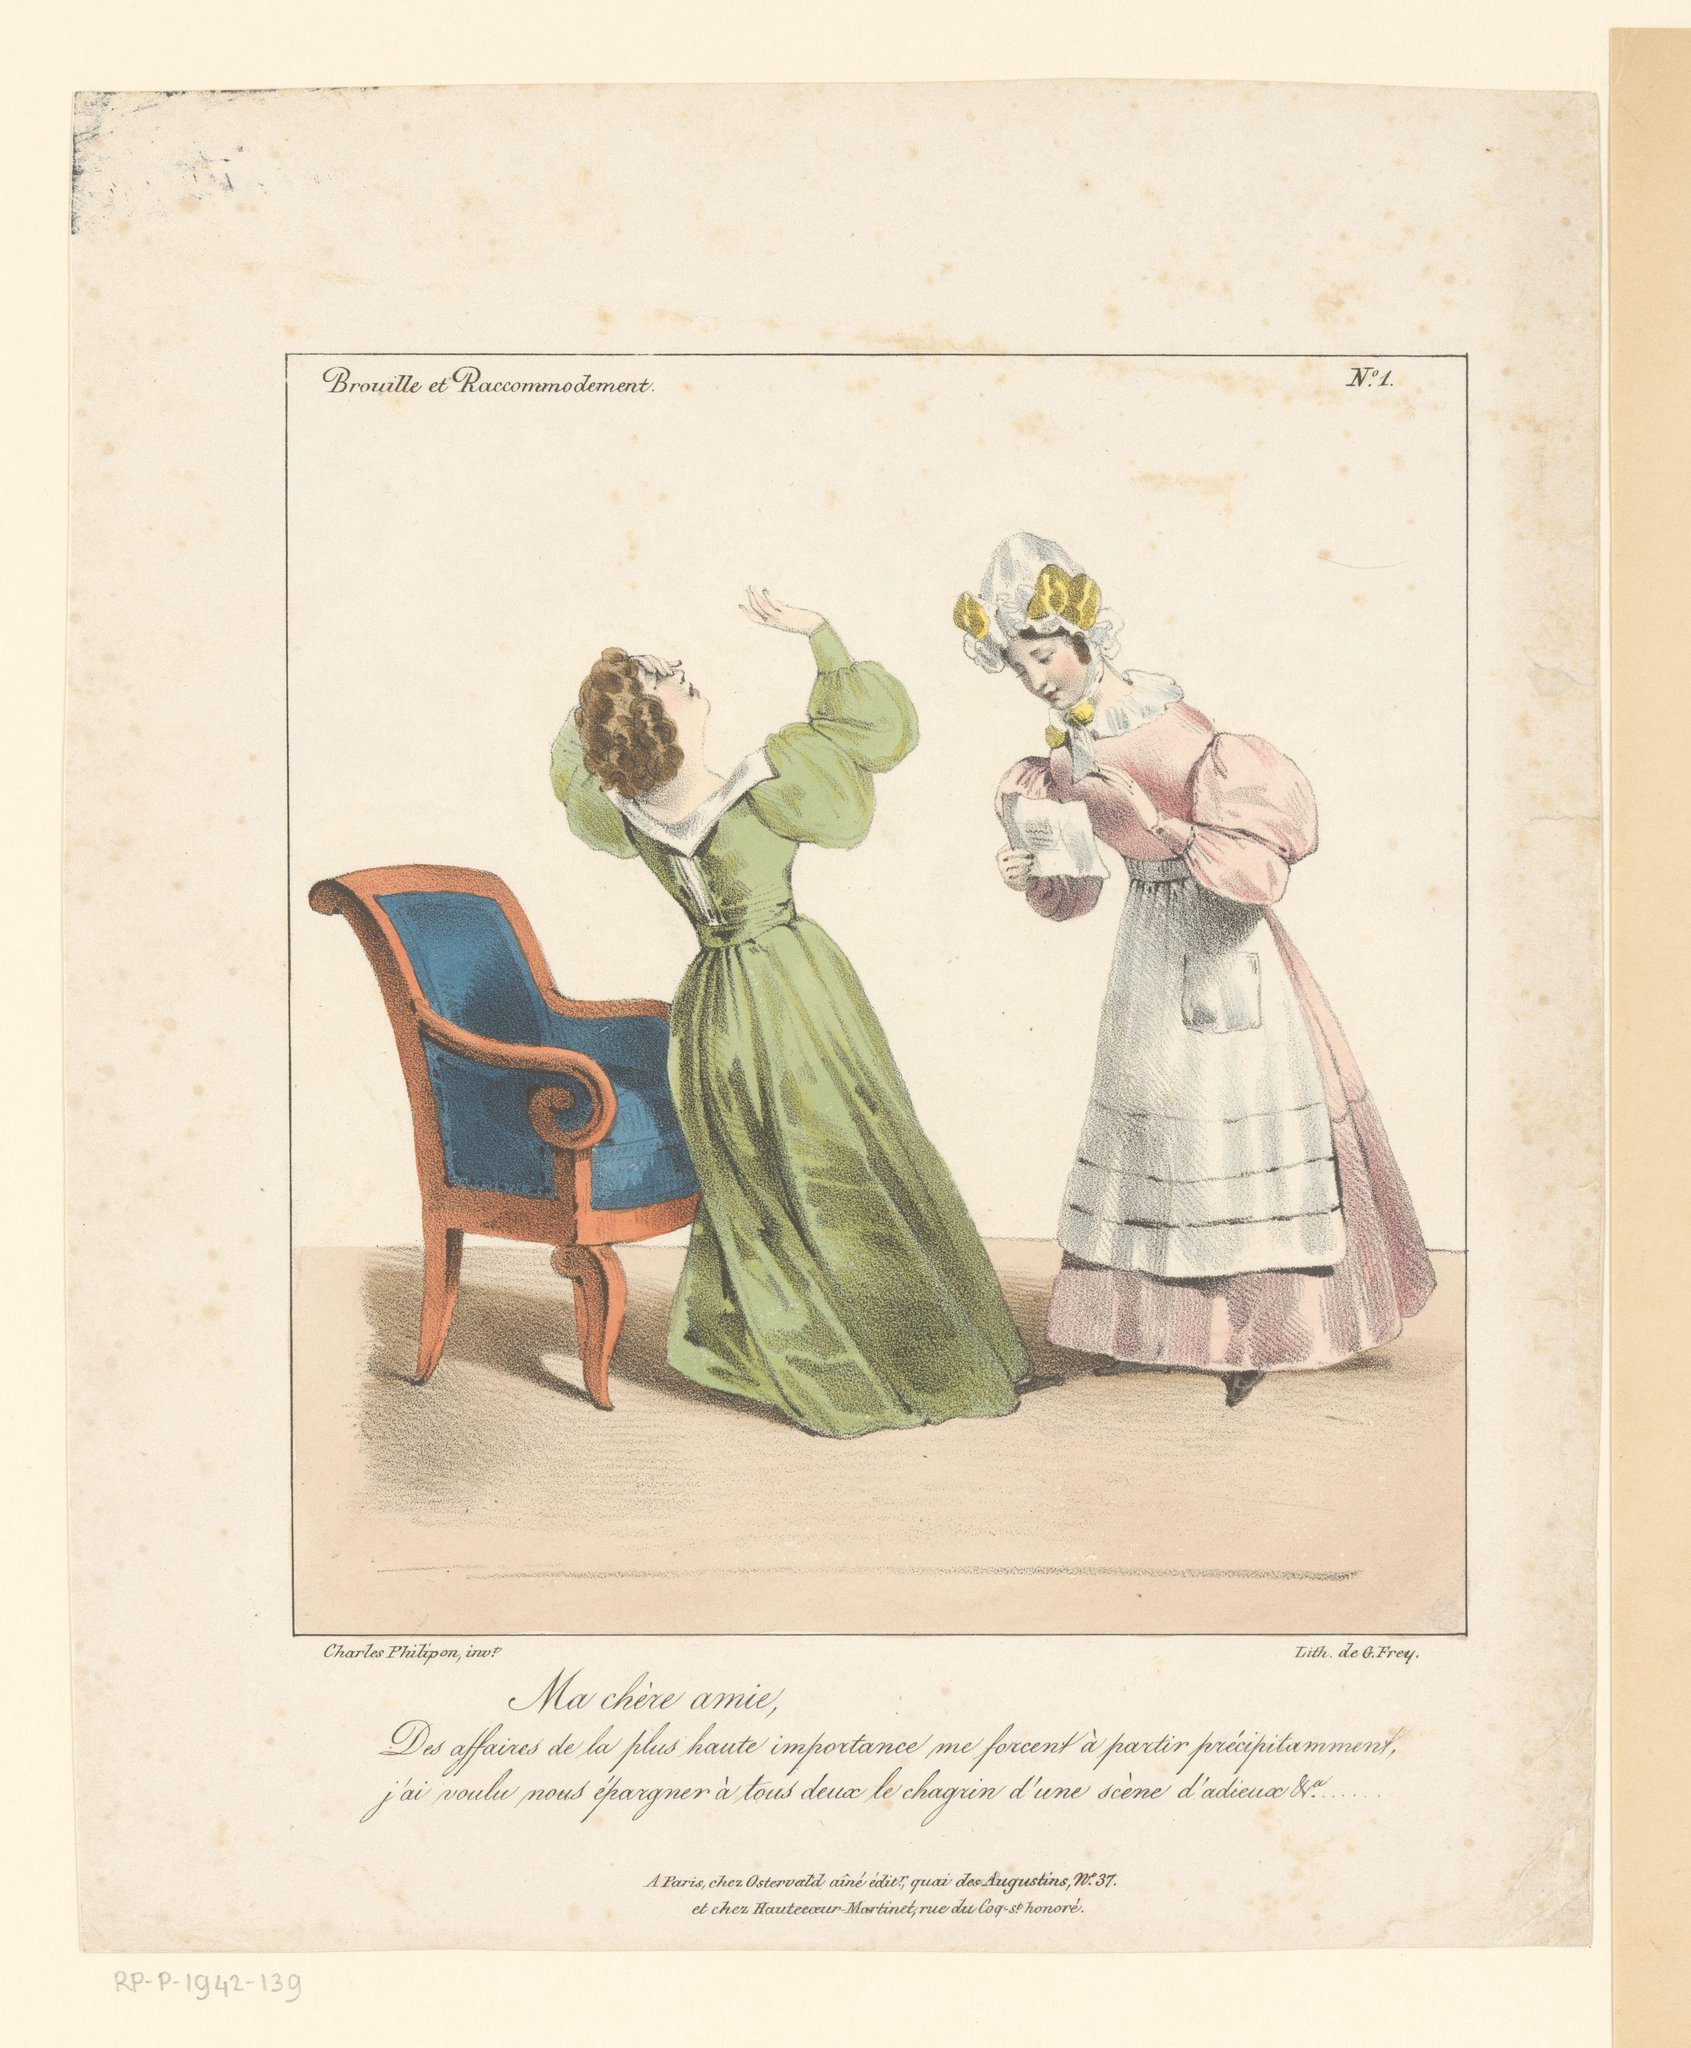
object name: print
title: Brouille et raccommodement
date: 1828-1830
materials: paper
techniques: hand coloring, lithograph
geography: paris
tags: adult woman, fainting, swooning, letter, envelope, end of a love affair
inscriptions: collector's mark: Lugt 2228, collector's mark: Lugt 2760